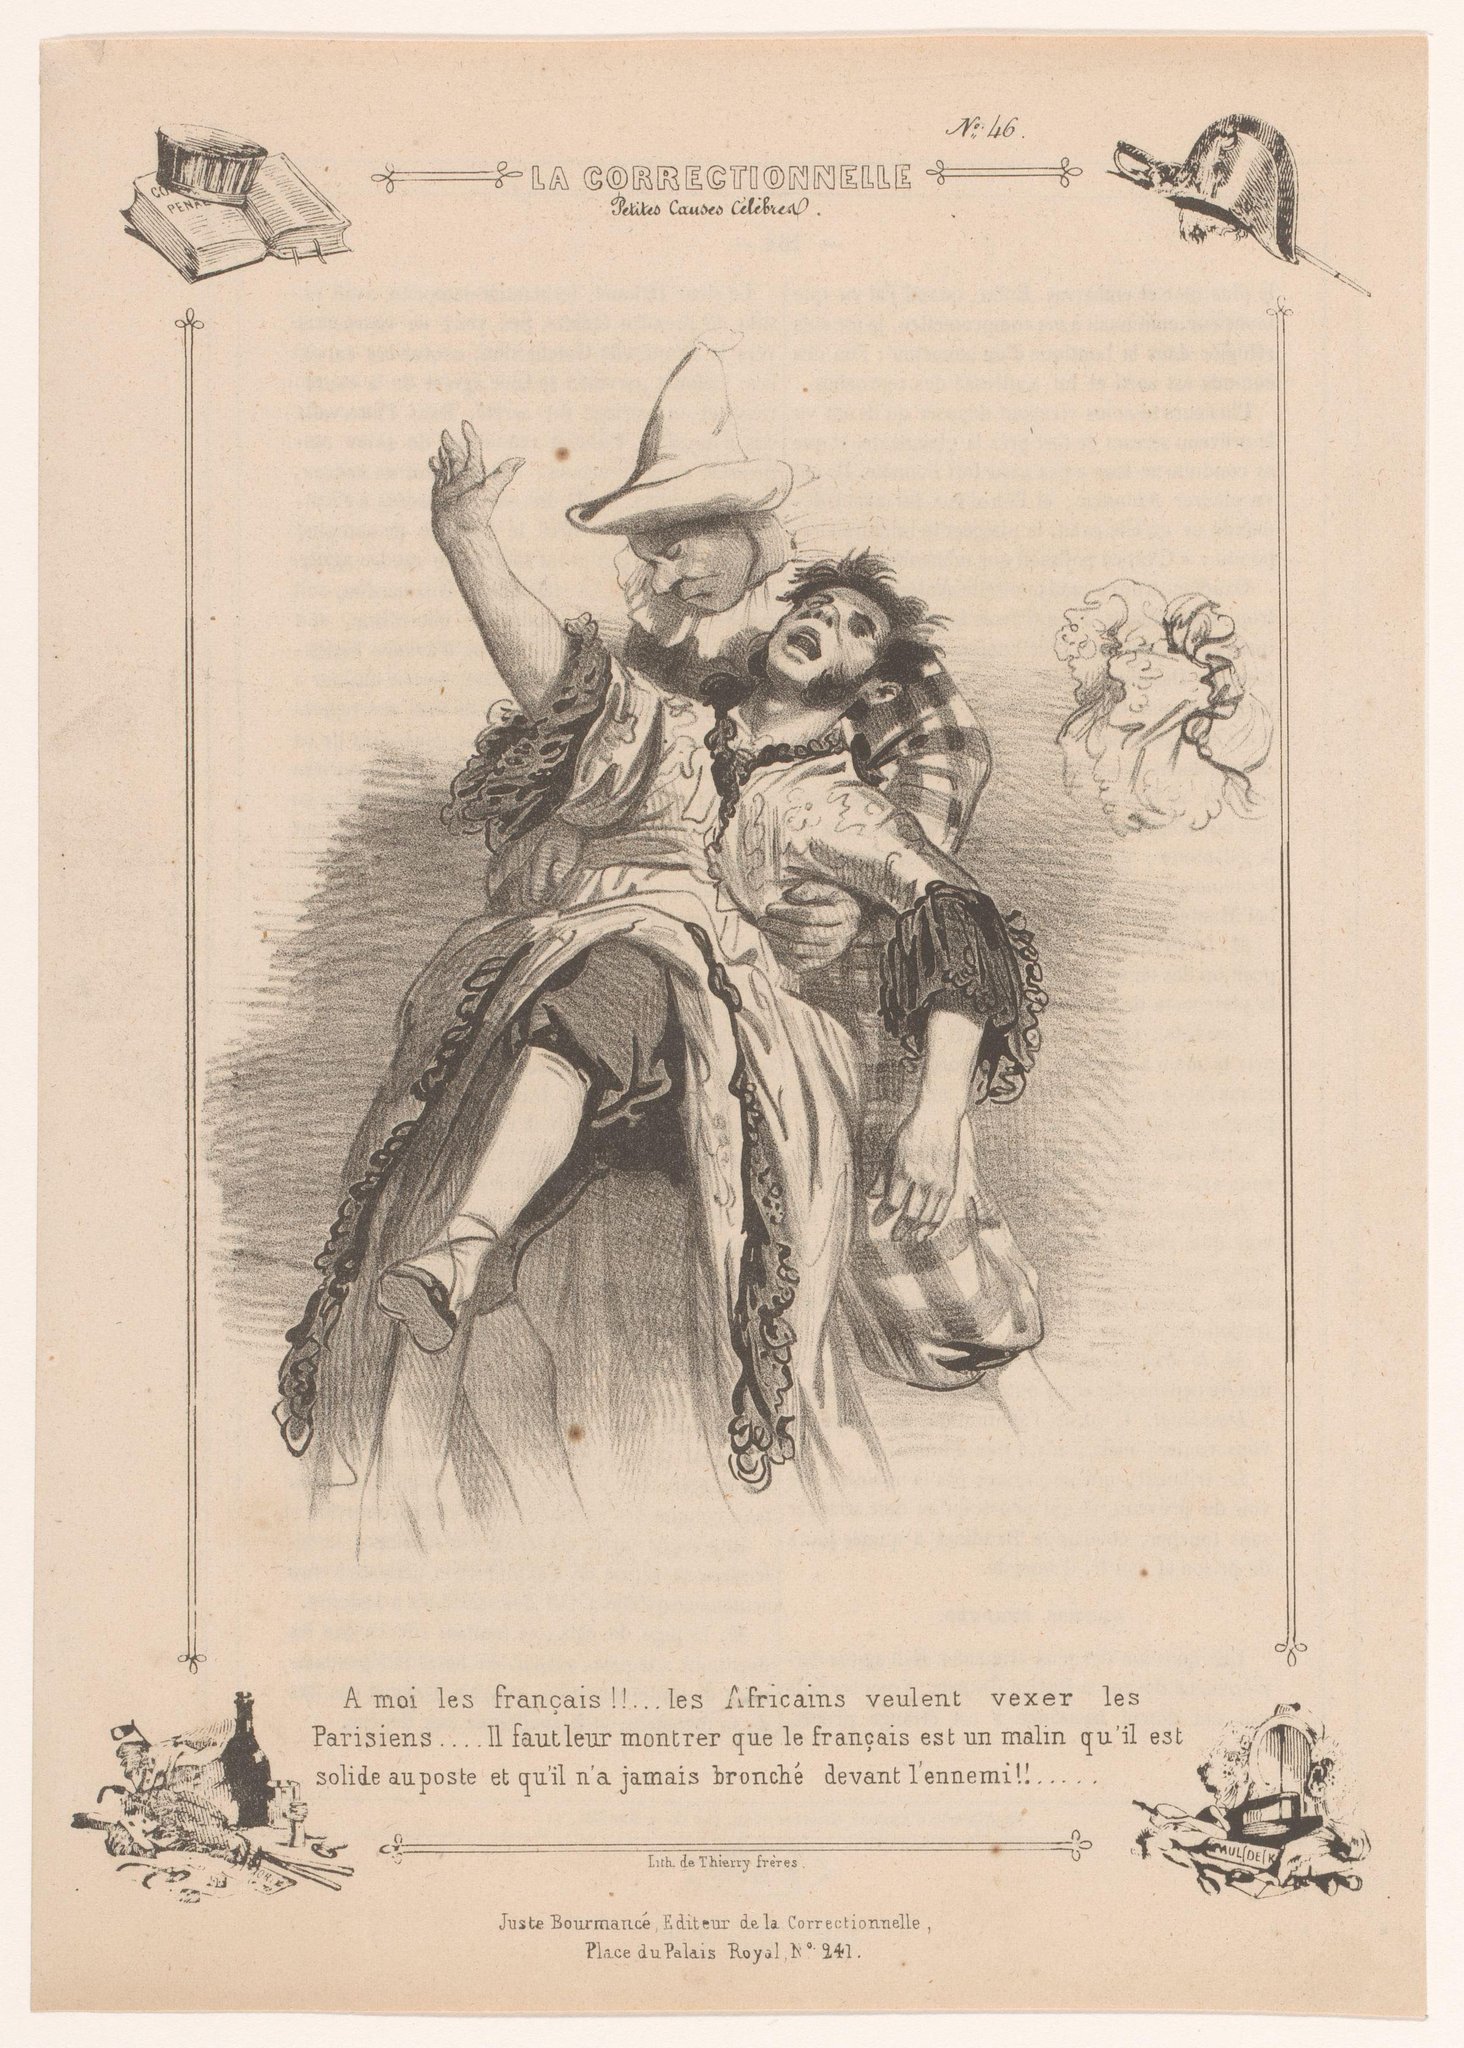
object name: print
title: Pivonnet wordt weggesleept uit een café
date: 1840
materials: paper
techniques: lithograph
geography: paris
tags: drunkard, disguise, crying, shouting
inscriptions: collector's mark: Lugt 2228a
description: Prent gepubliceerd in: Gavarni, P. La Correctionnelle. Petites causes célèbres. Études de moeurs populaires au dix-neuvième siècle. Parijs: Martinon, 1840. p. 183.